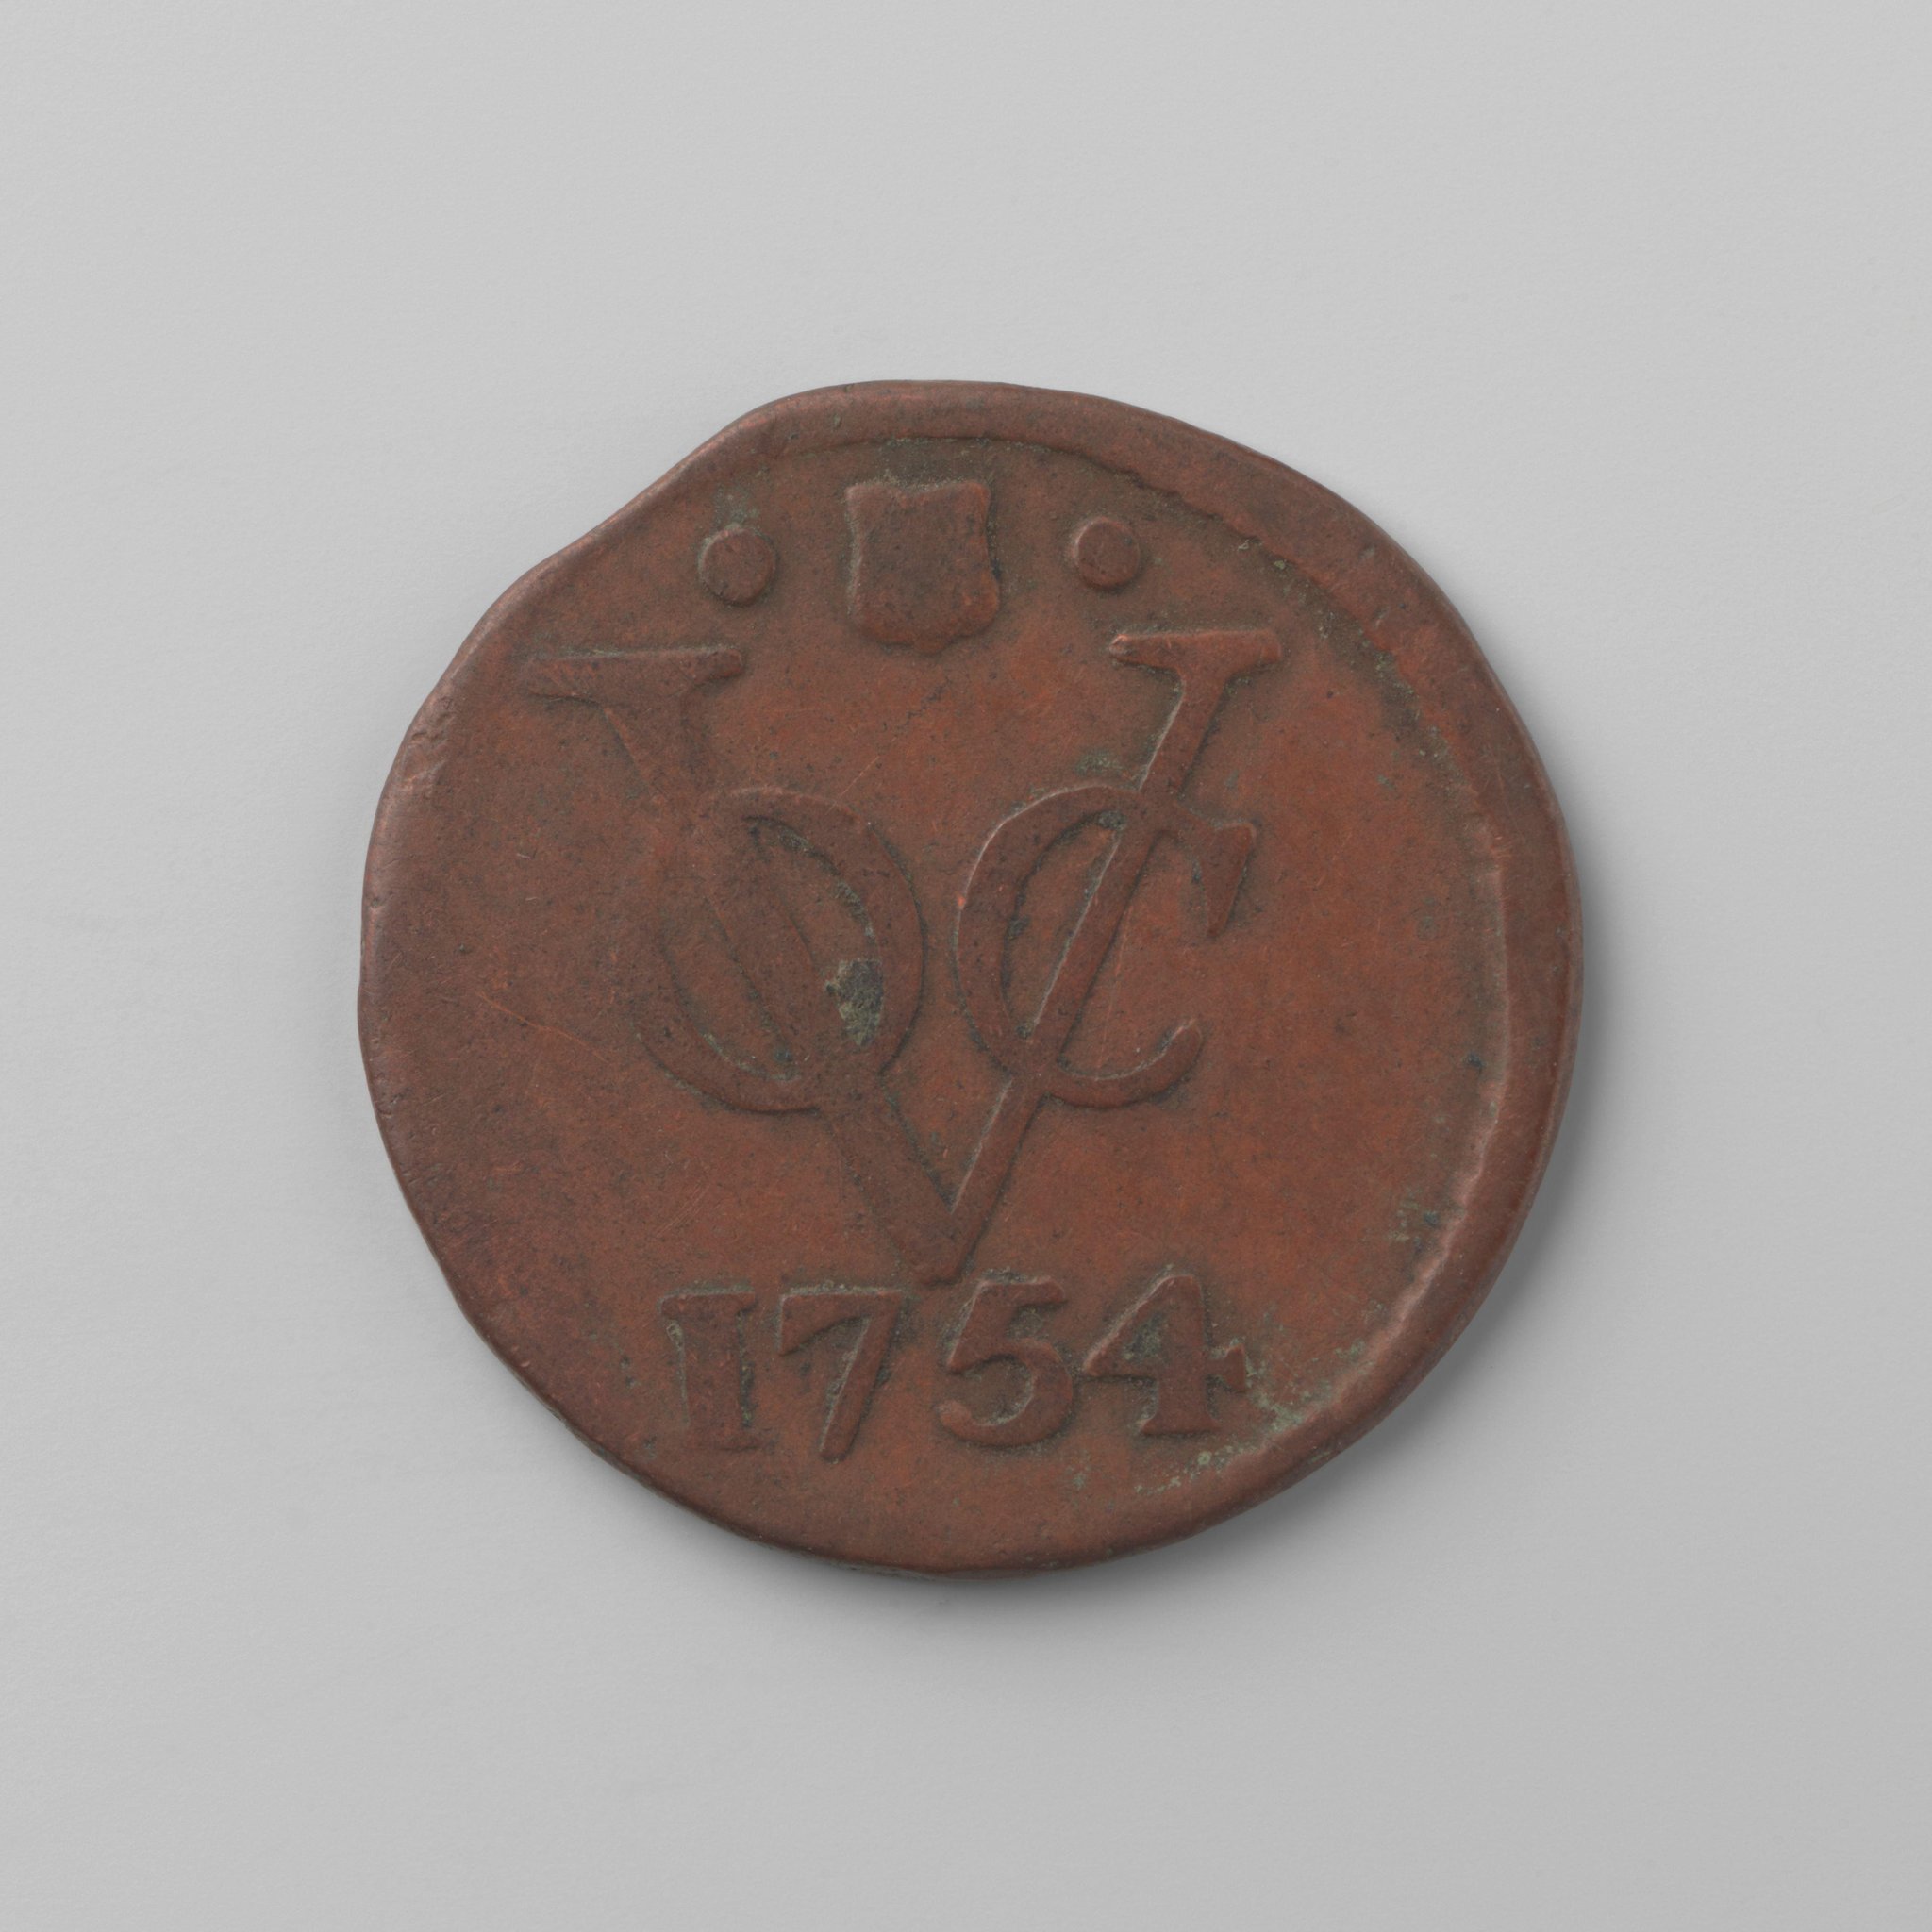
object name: coin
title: Duit van de VOC uit de stad Utrecht,1754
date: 1754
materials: copper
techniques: striking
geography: utrecht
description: Koperen munt. Voorzijde: op balk, waaronder guirlande, geplaatst, door twee leeuwen gehouden gekroond wapenschild van de stad Utrecht. Keerzijde: monogram van de VOC, waarboven muntteken en waaronder jaartal. Gladde rand.